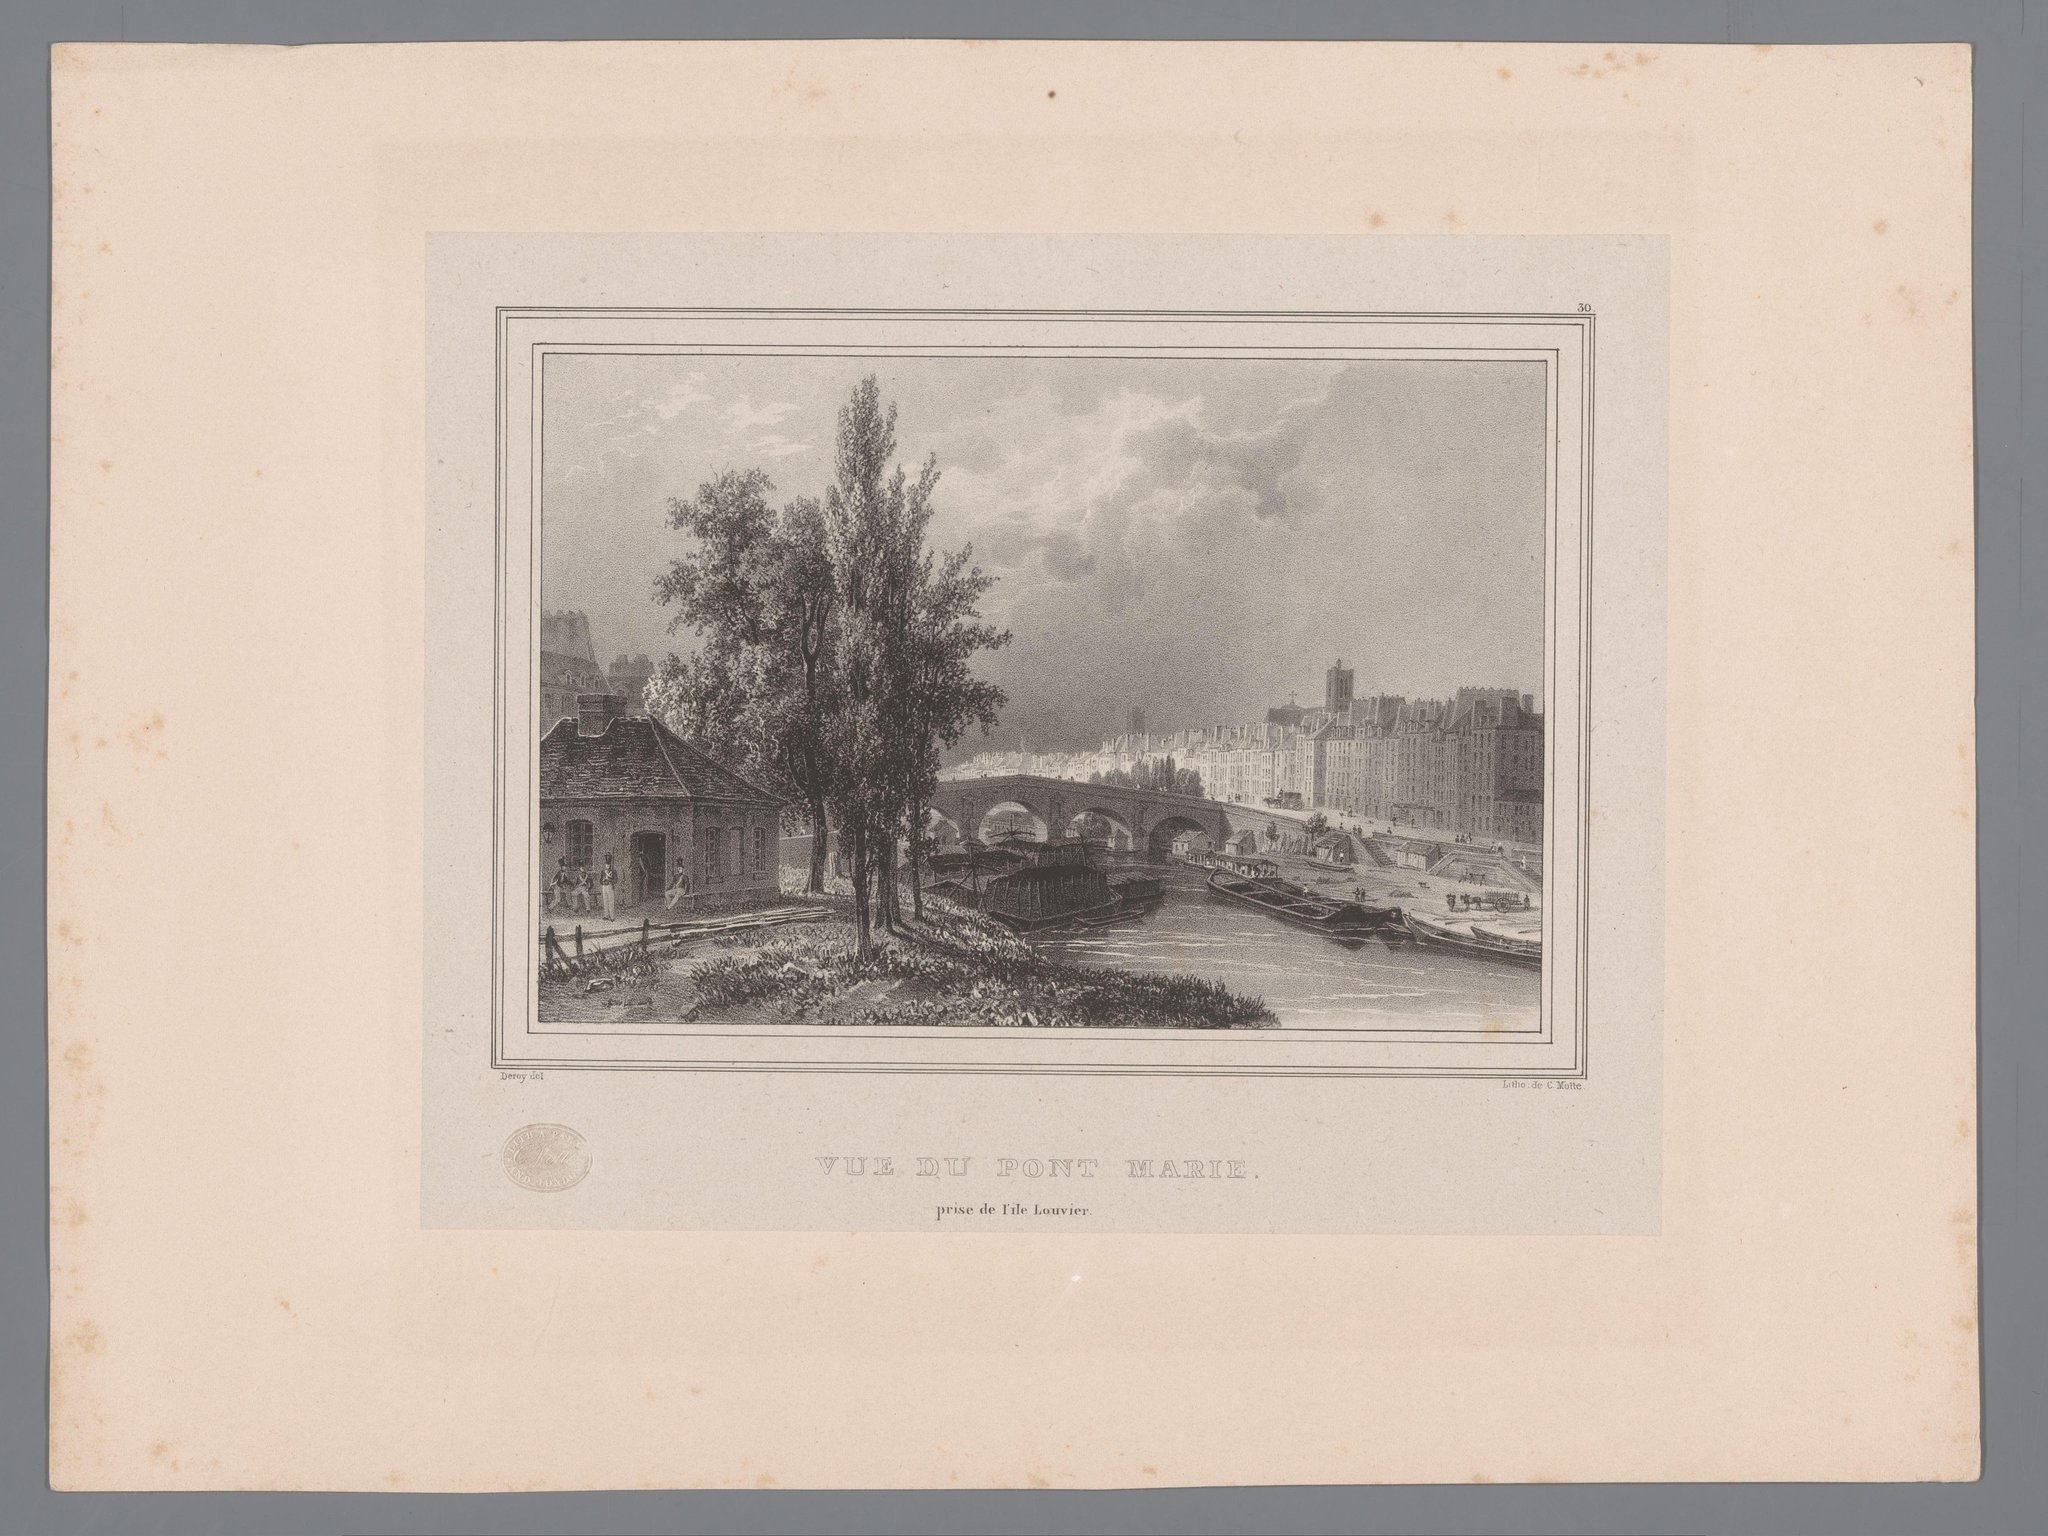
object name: print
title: Gezichten aan de oevers van de Seine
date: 1829-1831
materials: paper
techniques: lithograph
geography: paris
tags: bridge in city across river, canal, etc., river (+ landscape with figures, staffage), prospect of city, town panorama, silhouette of city (+ city(-scape) with figures, staffage)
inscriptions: check stamp: Lugt 1828b, collector's mark: Lugt 2228a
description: Prent maakt deel uit van een omslag met dertien prenten.